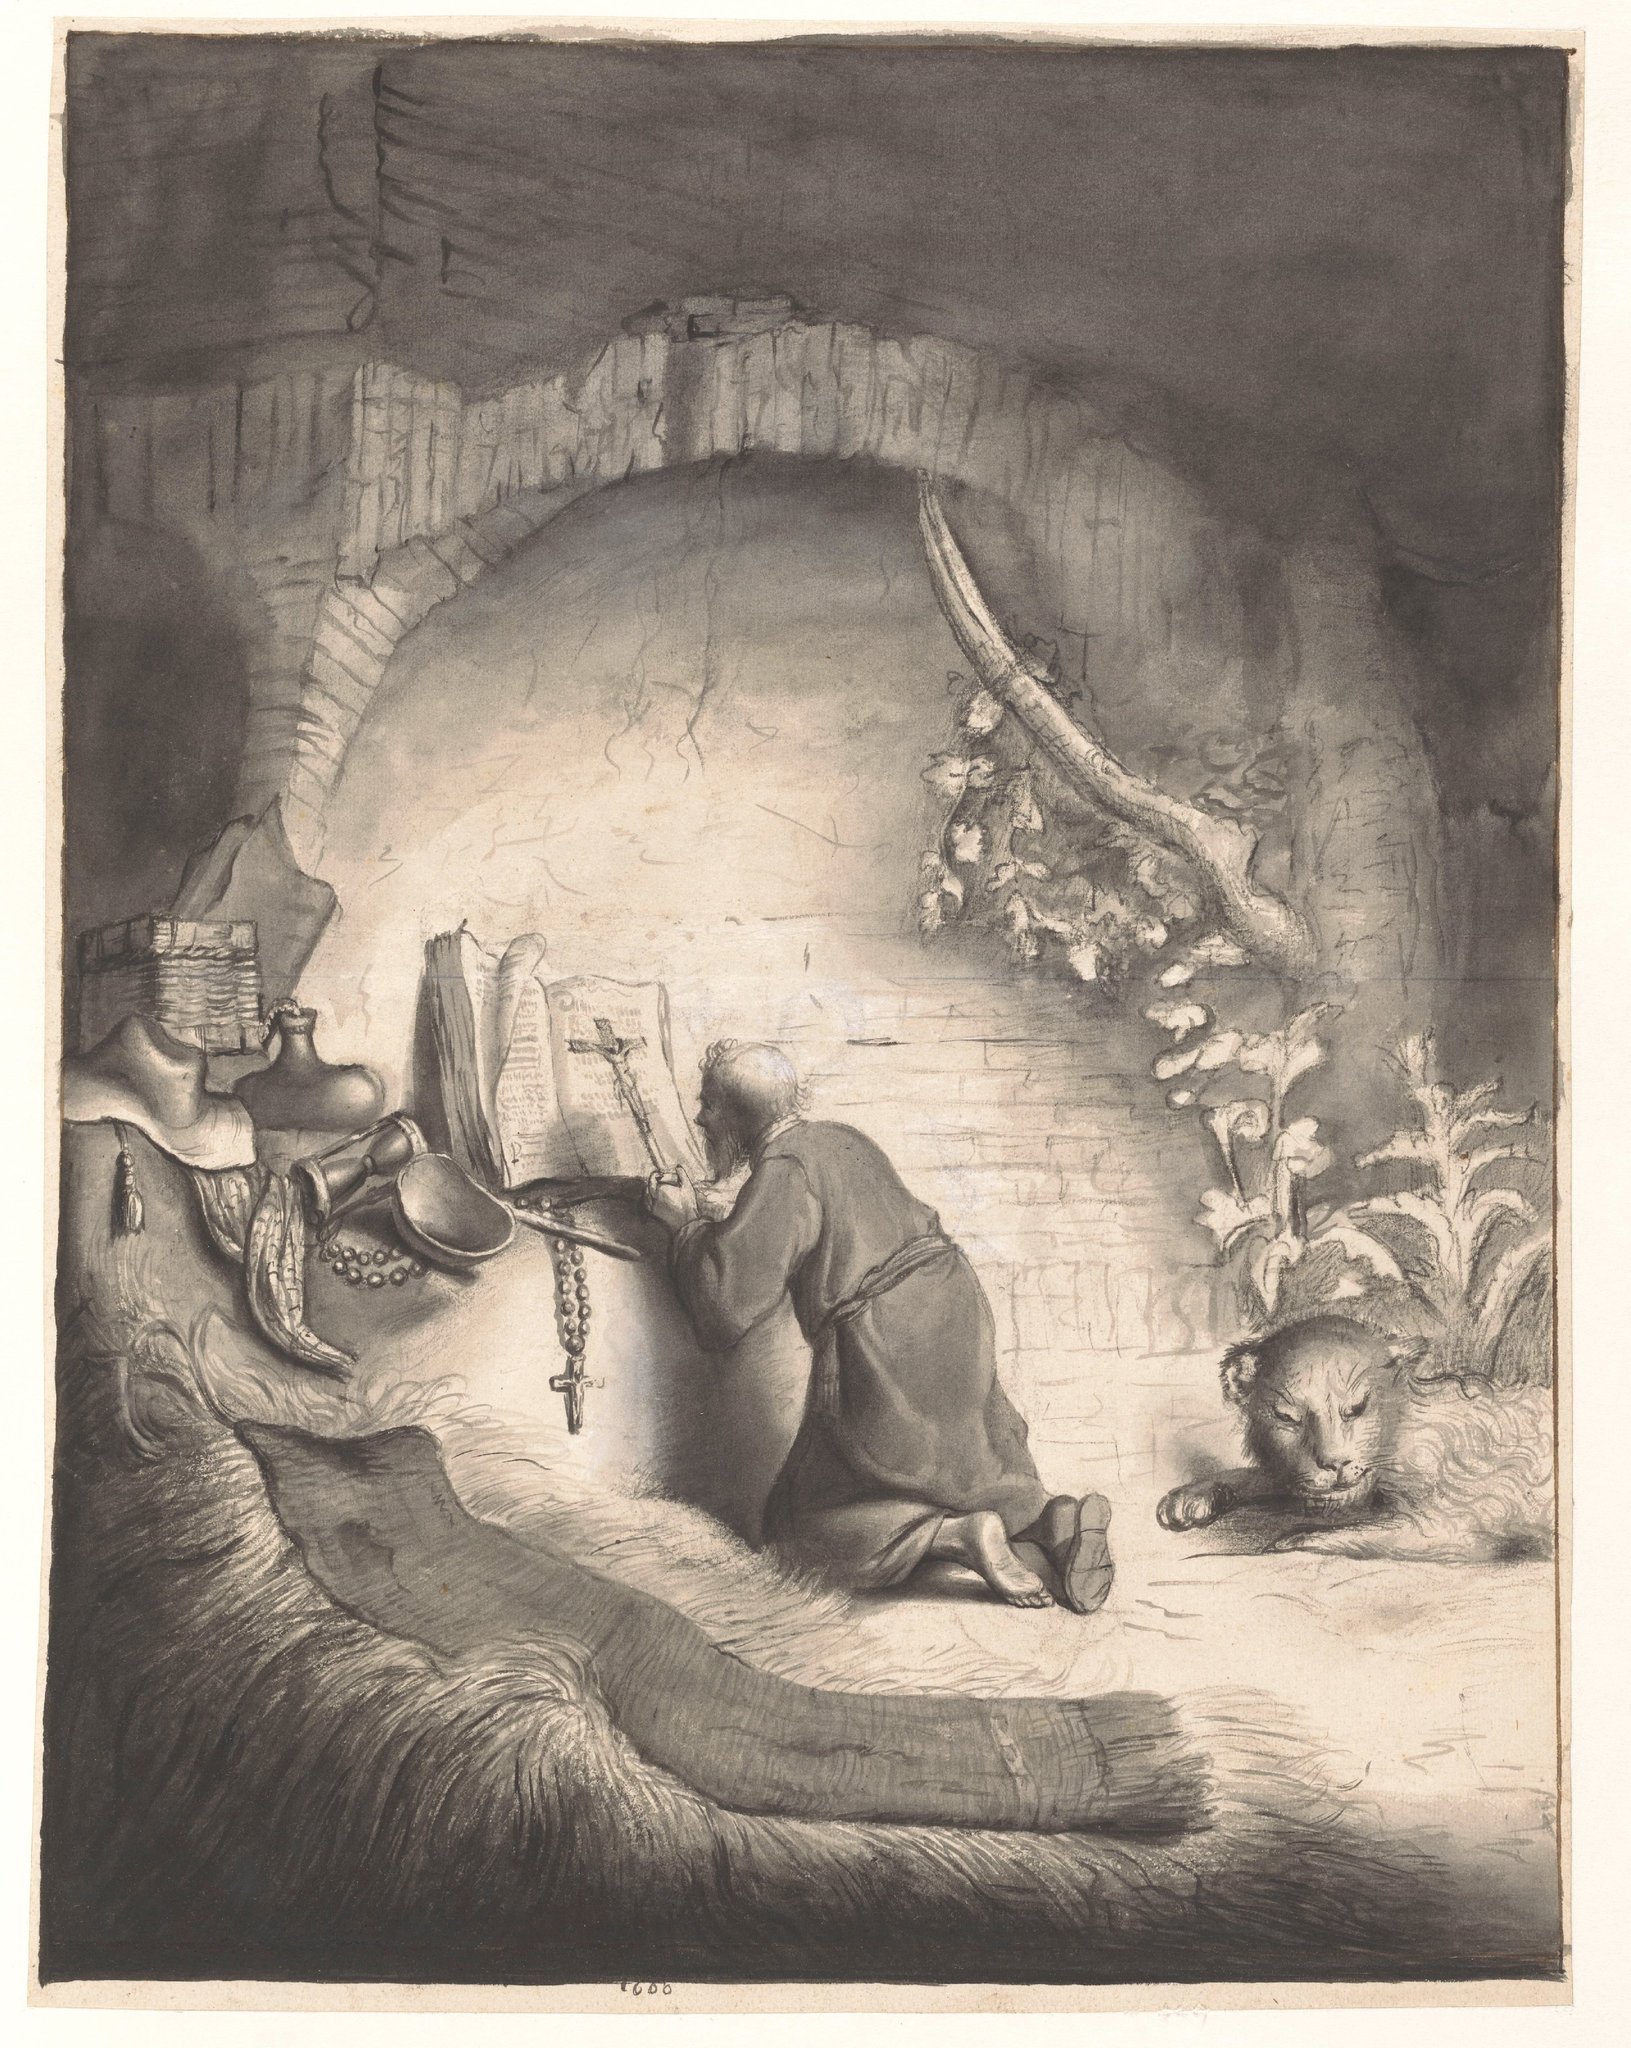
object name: drawing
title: Heilige Hieronymus en de leeuw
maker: moses ter borch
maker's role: draughtsman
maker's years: 1645-1667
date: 1660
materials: chalk, paint, gouache, ink, paper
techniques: brush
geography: zwolle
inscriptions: annotation: ‘naar v.Vliet naar Rembr/ Bartsch 13’, date: ‘1660’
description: Naar ets van J.G. van Vliet naar Rembrandt (B.13, 1631).